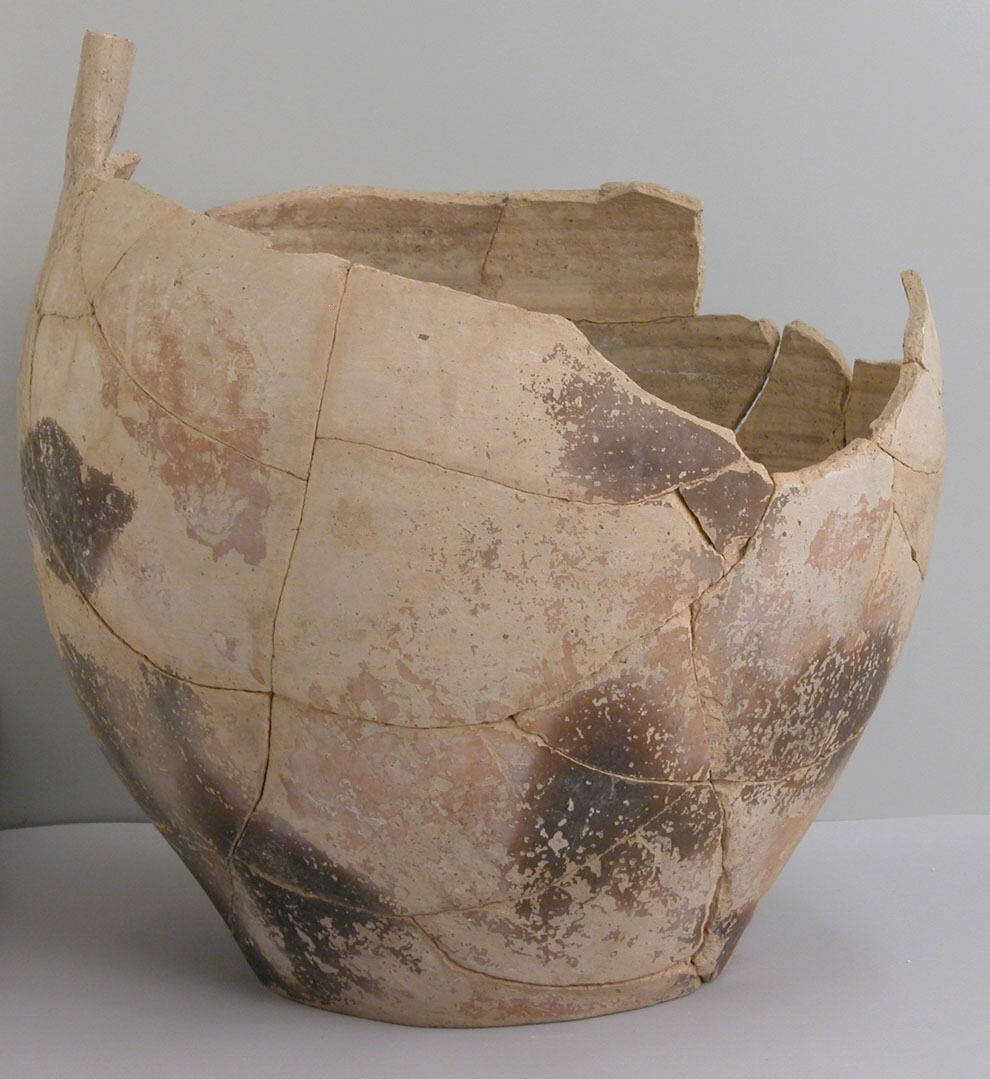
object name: jar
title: Fragmentary Jar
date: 501-700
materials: earthenware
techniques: incising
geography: iran